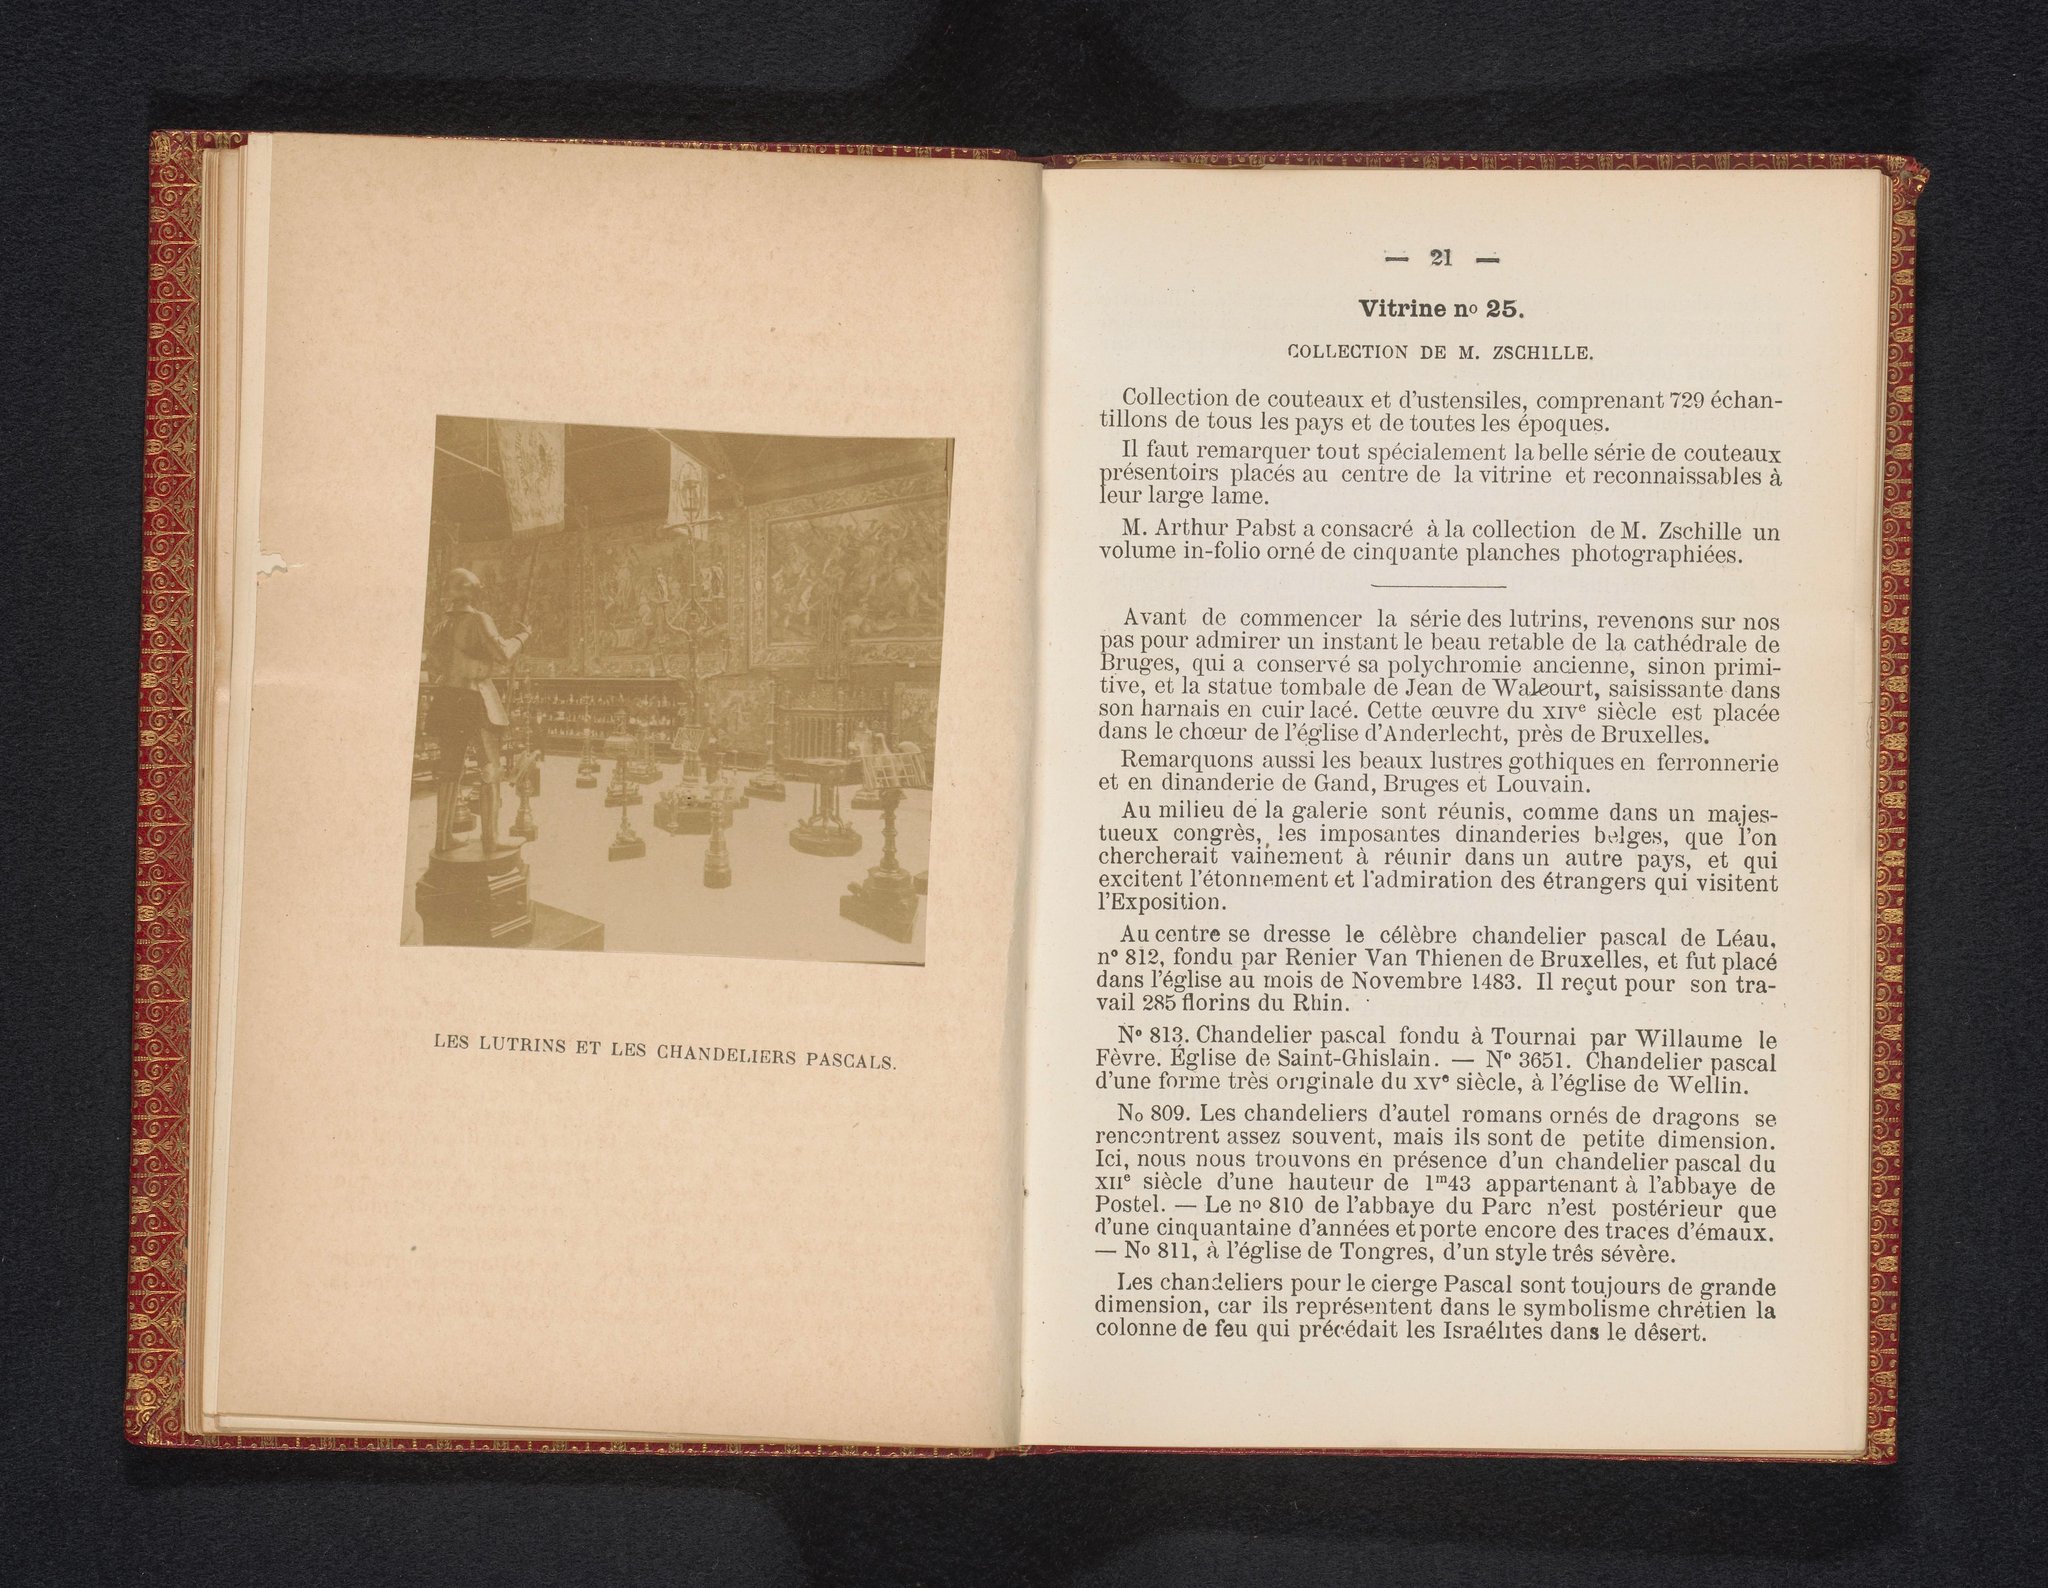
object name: photograph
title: Les lutrins et les chandeliers pascals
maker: Anonymous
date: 1888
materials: photographic support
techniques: albumen print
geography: brussels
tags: lectern, permanent exhibition, museum, candlestick, brussels